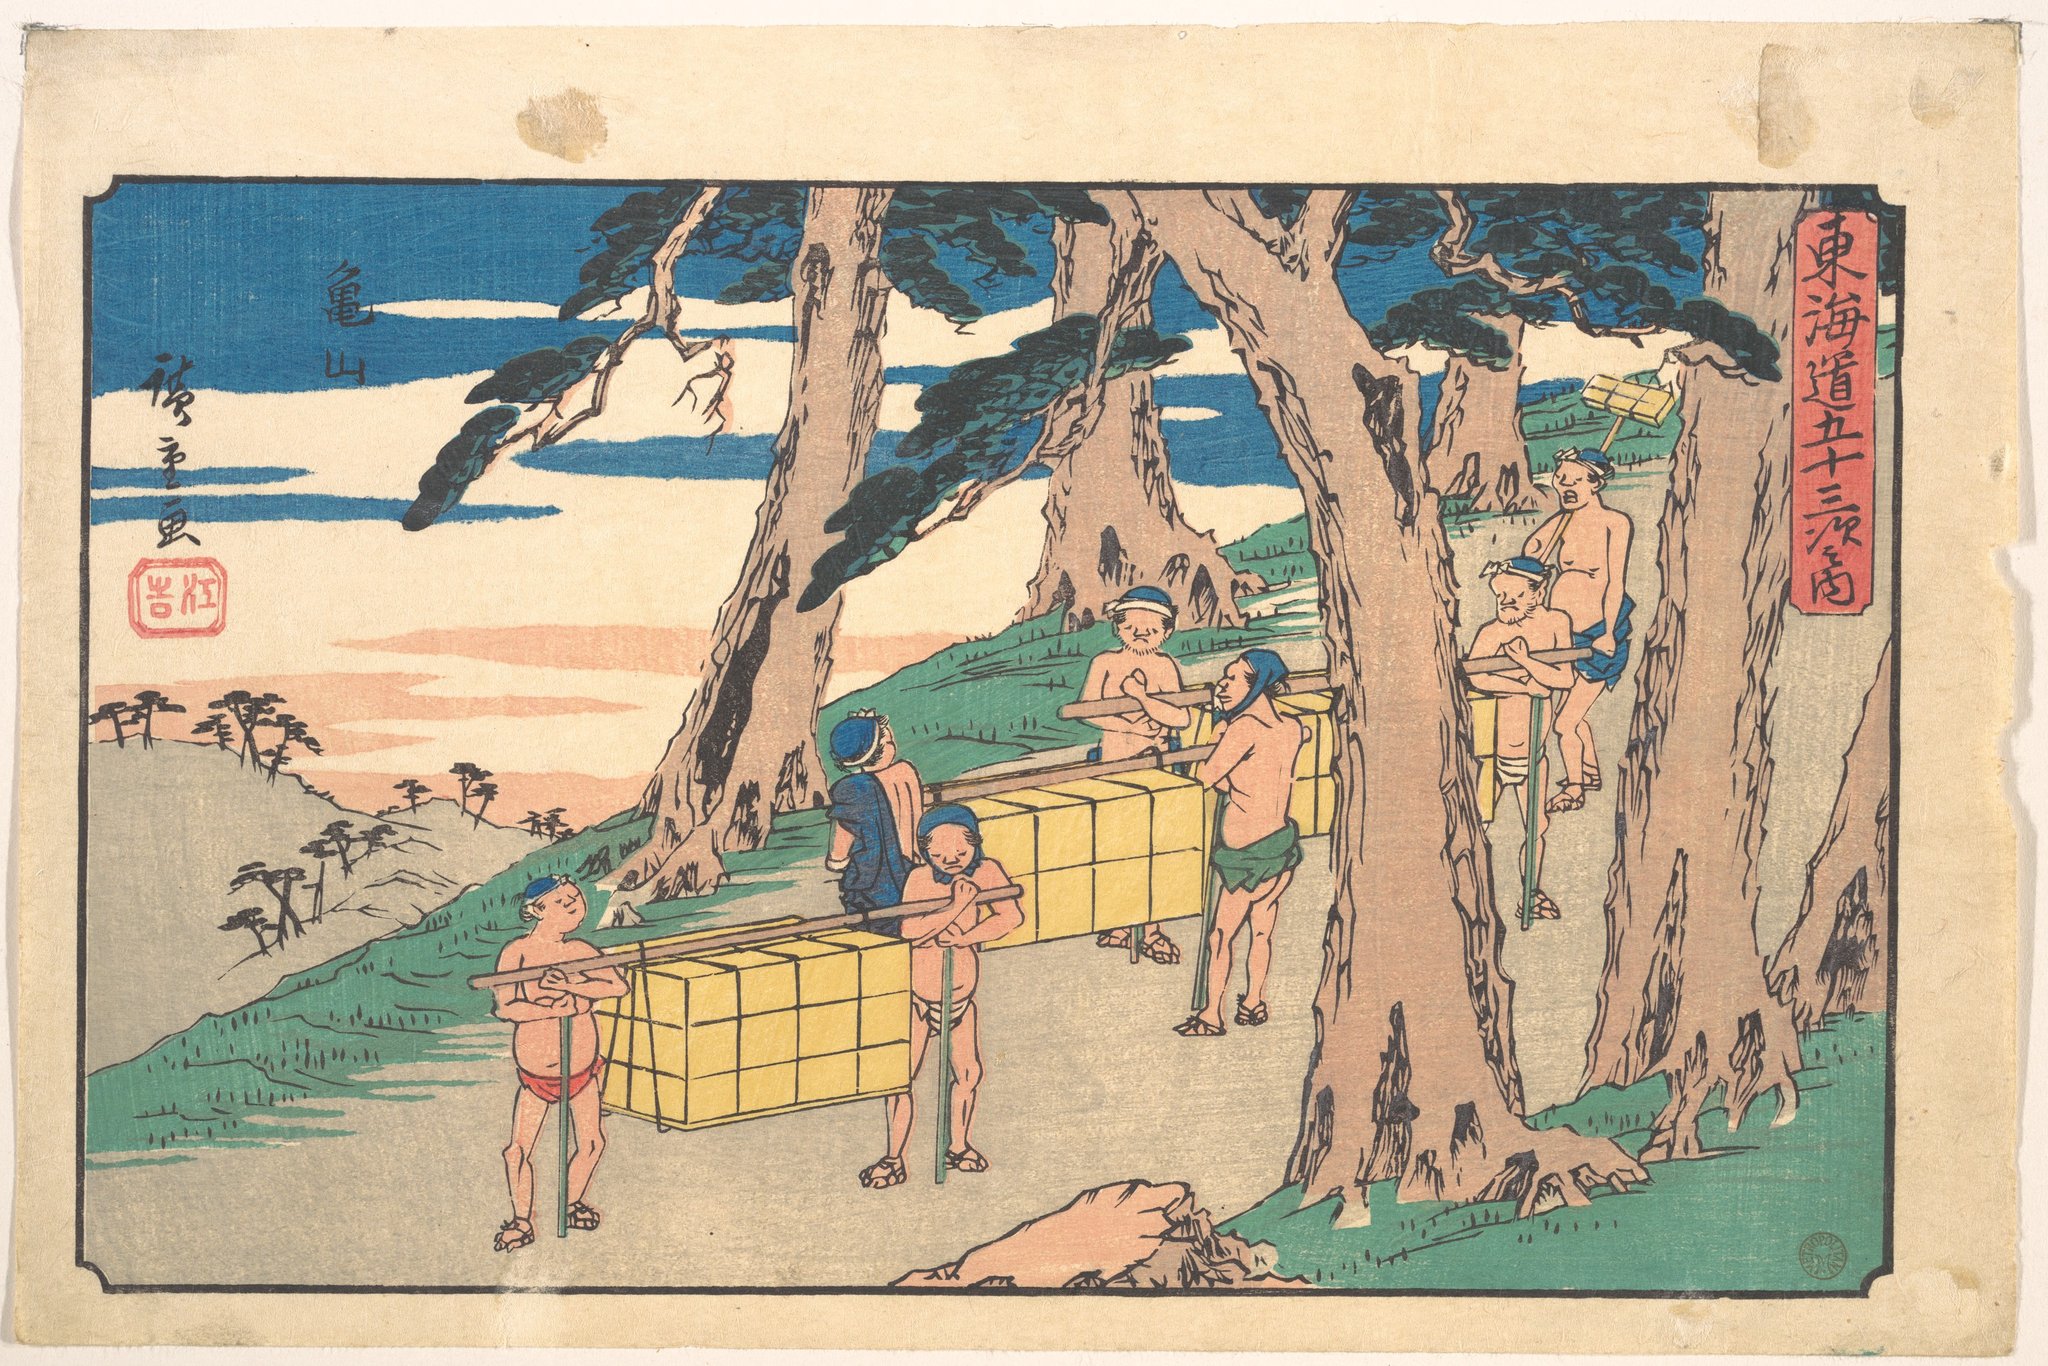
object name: print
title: Kameyama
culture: japanese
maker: utagawa hiroshige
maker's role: artist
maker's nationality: japanese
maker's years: 1797-1858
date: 1842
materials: ink, paper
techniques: woodblock print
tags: men,trees,working